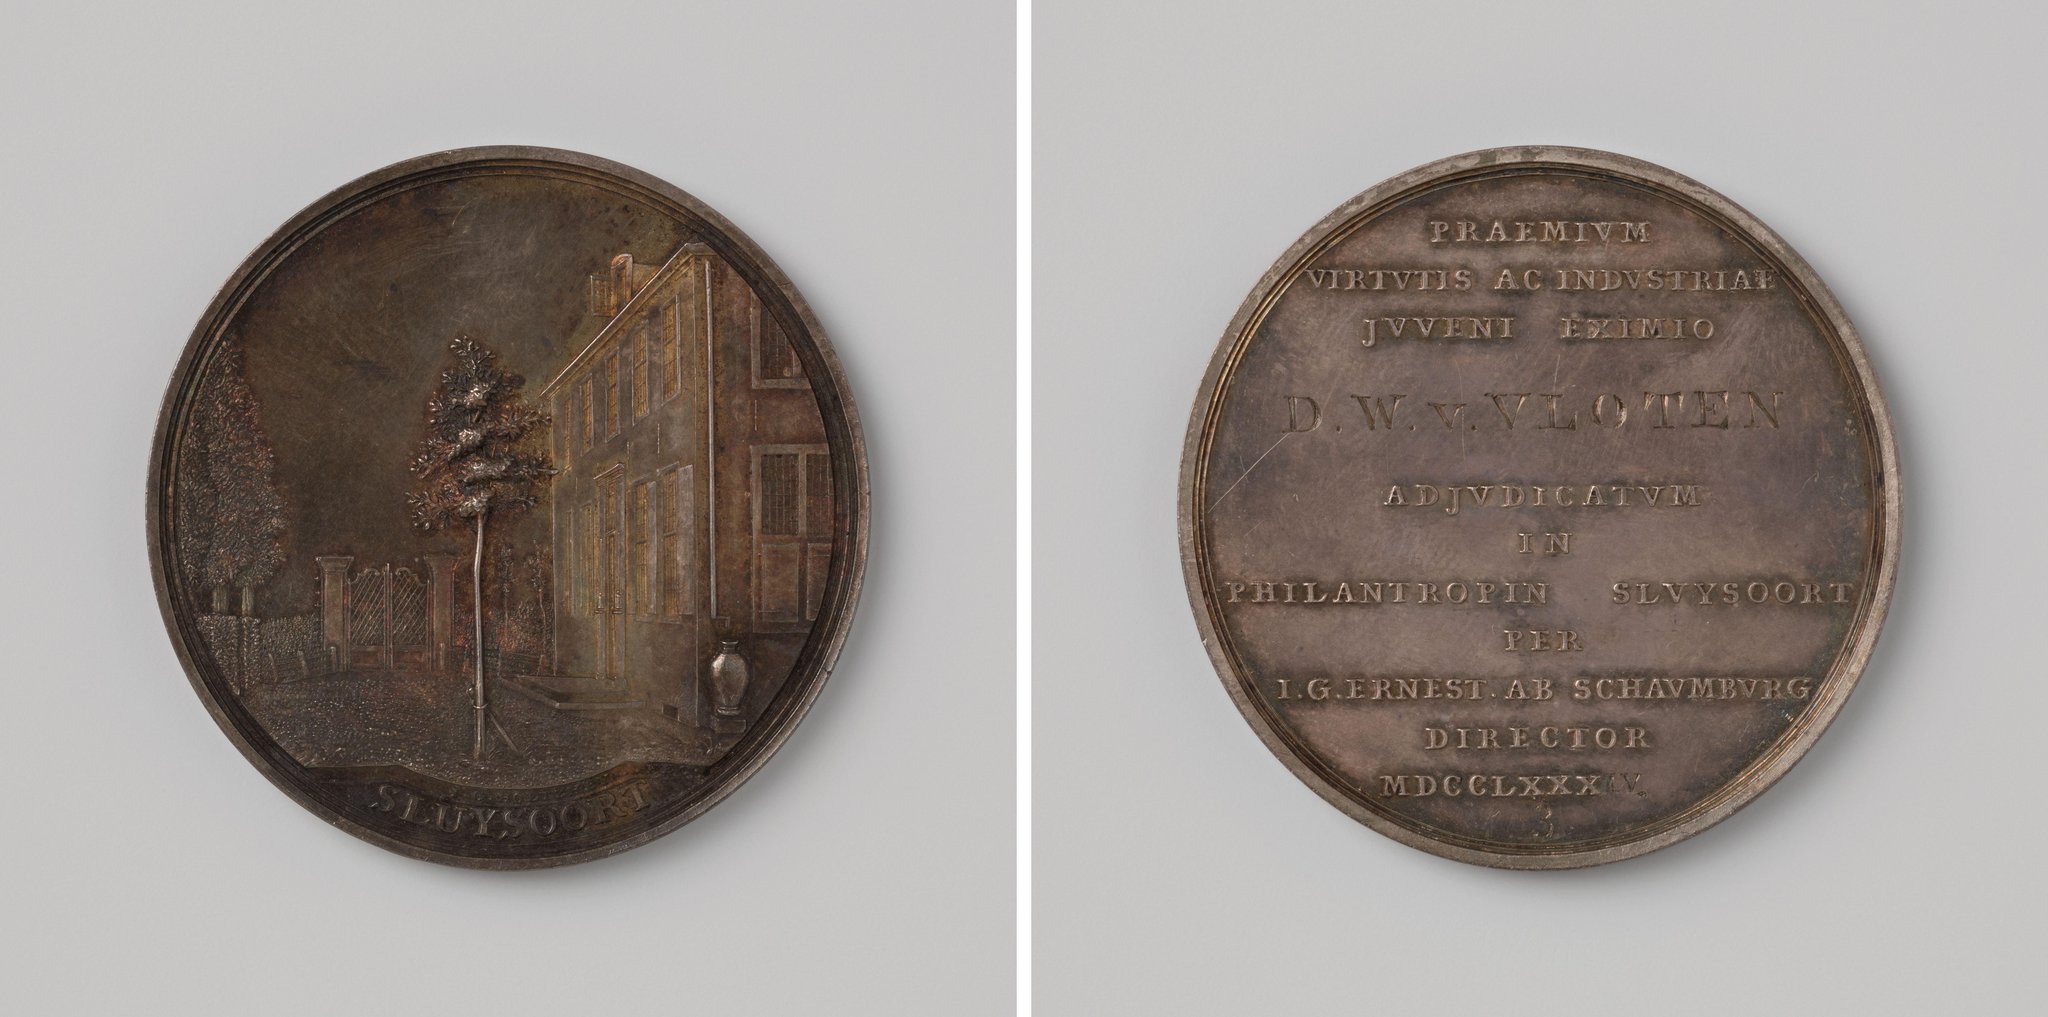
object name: honorary medal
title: Opvoedingsgesticht Sluysoort, toegekend aan D.W. Vloten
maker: johan george holtzhey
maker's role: mintmaster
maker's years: 1726-1808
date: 1784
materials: silver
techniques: striking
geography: amsterdam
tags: d.w. vloten, j.g. ernst van schaumburg, sluysoort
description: Zilveren penning. Voorzijde: gezicht op het gesticht; daarnaast boom. Keerzijde: opschrift